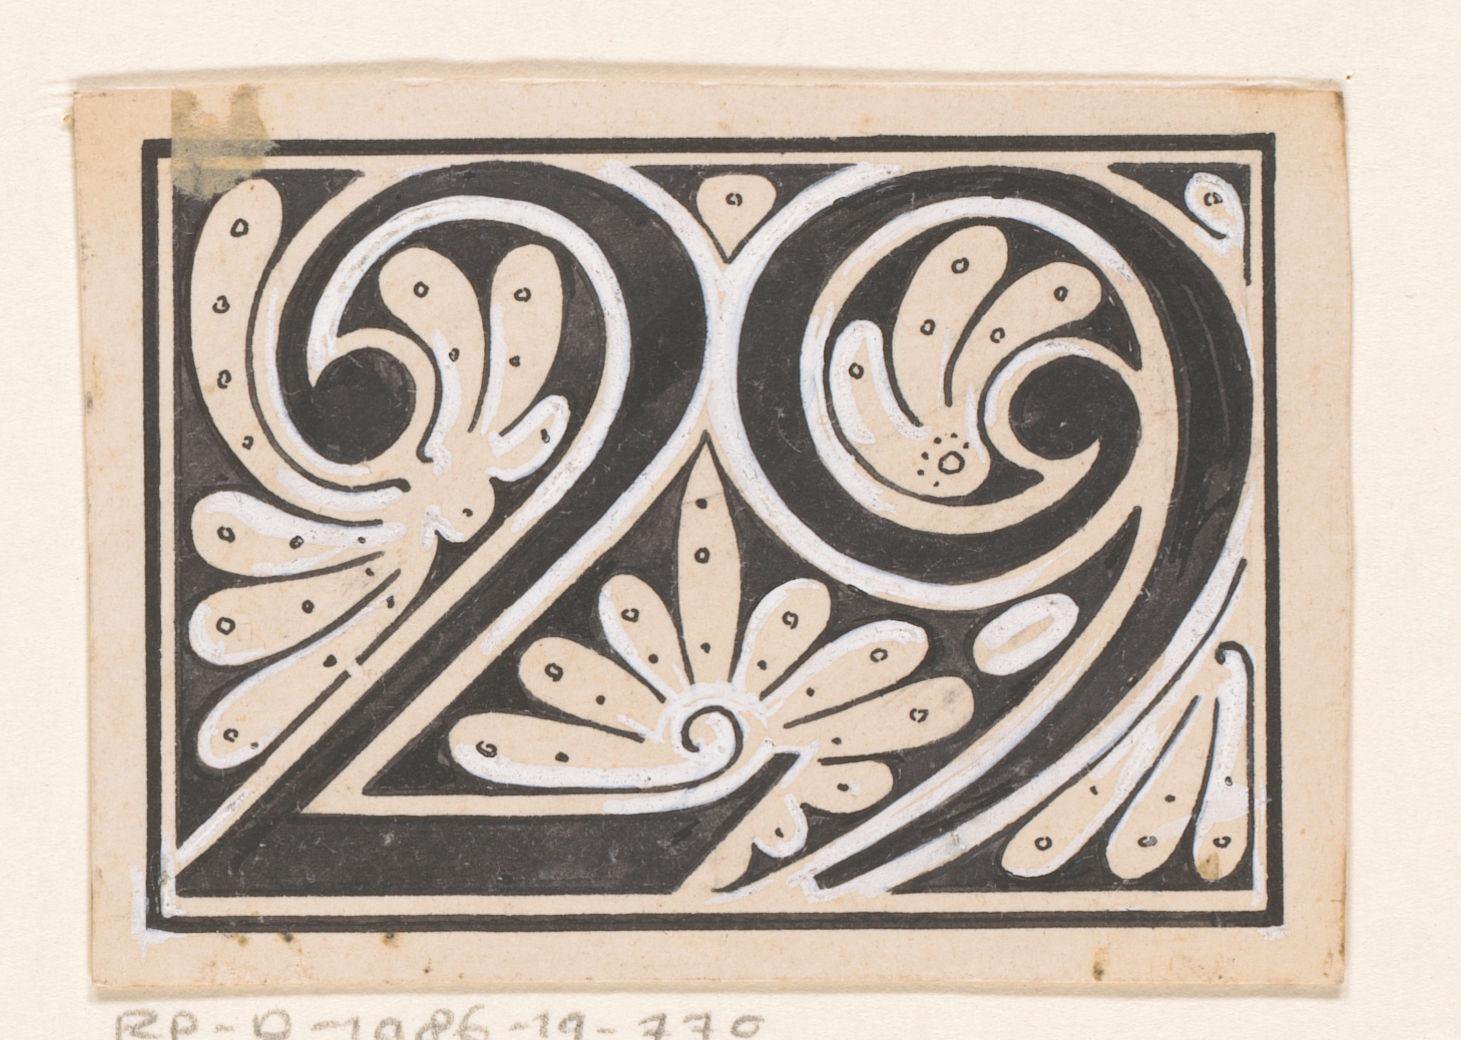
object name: design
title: Getal 29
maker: reinier willem petrus de vries (1874-1953)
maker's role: draughtsman, print maker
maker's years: 1874-1953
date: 1904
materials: paint, ink, paper, pencil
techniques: brush, pen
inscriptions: collector's mark: ‘R:MVS.’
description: Het getal is gebruikt voor: Veth, Jan. Jozef Israëls en zijn kunst. Arnhem en Nijmegen: Gebroeders E&M Cohen, 1904.